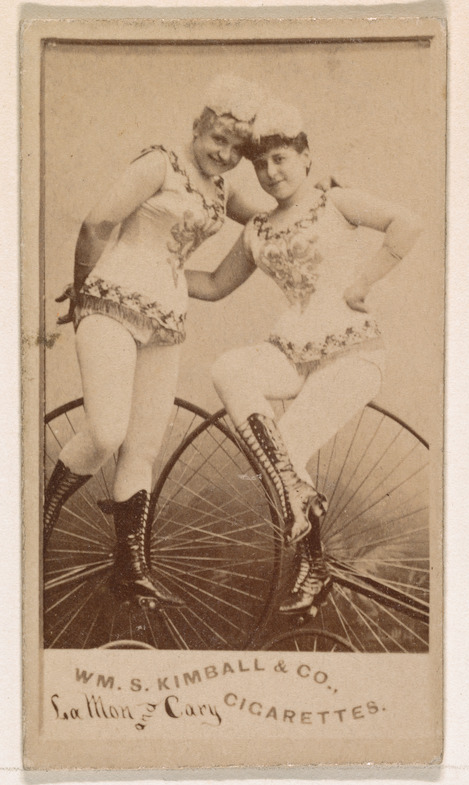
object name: photograph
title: La Mon and Cary, from the Actresses series (N203) issued by Wm. S. Kimball & Co.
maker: william s. kimball & company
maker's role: publisher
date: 1889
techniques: color lithograph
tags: portraits,women,actresses